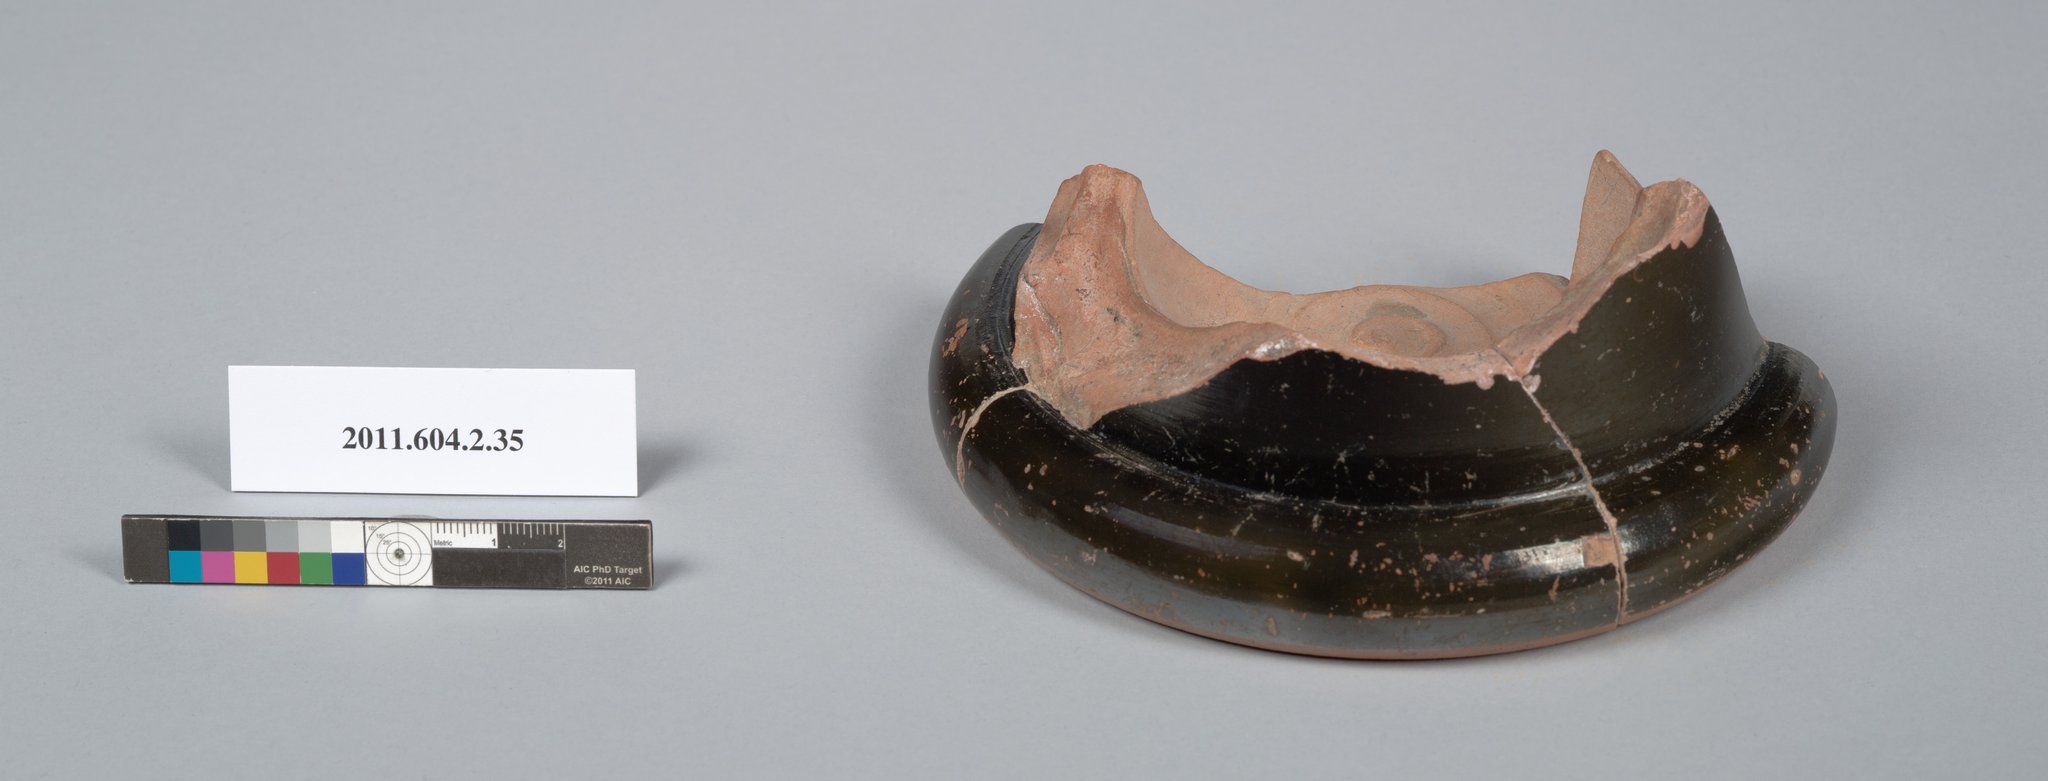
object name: psykter fragment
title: Terracotta fragment of a psykter (vase for cooling wine)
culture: greek, attic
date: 534-468 BCE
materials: terracotta